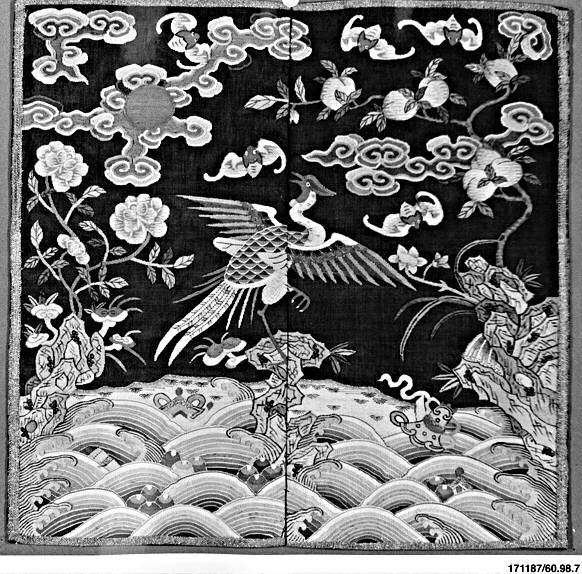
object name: rank badge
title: Rank Badge with Golden Pheasant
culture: chinese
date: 1901-1950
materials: metal thread, silk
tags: bats,pheasants